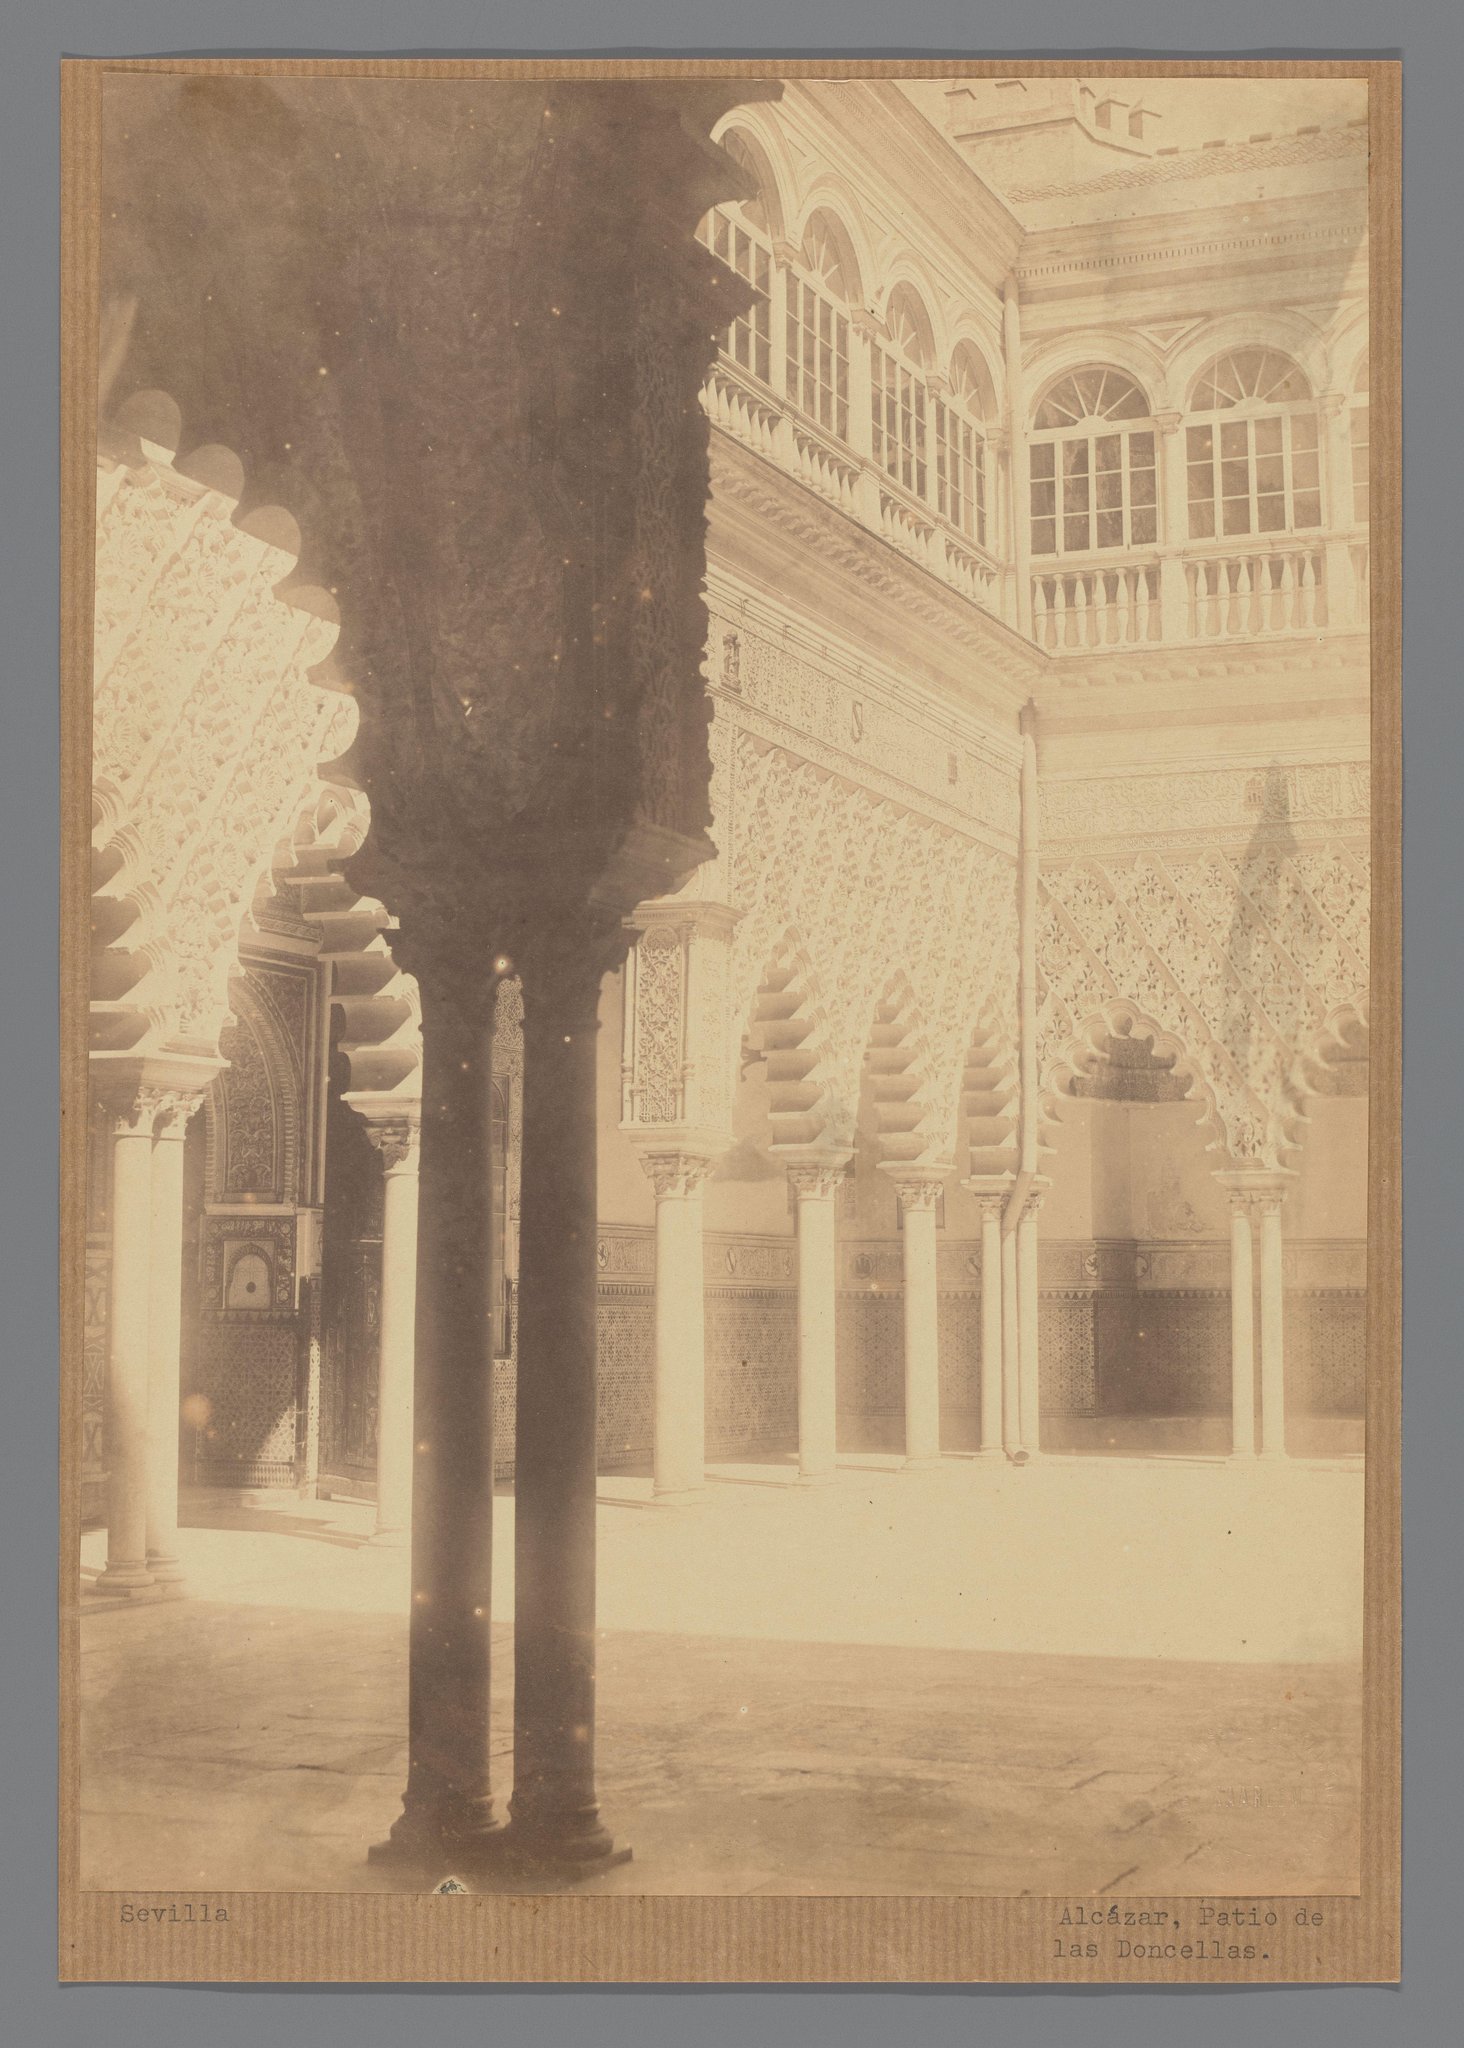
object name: photograph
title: Sevilla Alcazar, Patio de las Doncellas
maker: manuel freyre reynoso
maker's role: fotograaf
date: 1850-1899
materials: paper, photographic support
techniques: albumen print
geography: spain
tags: koninklijk paleis van sevilla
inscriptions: inscription, stamp: ‘UNIVERSITEIT VAN AMSTERDAM / KUNST / HISTORISCH / INSTITUUT’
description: Foto uit de studiecollectie van het Kunsthistorisch Instituut van de Universiteit van Amsterdam.